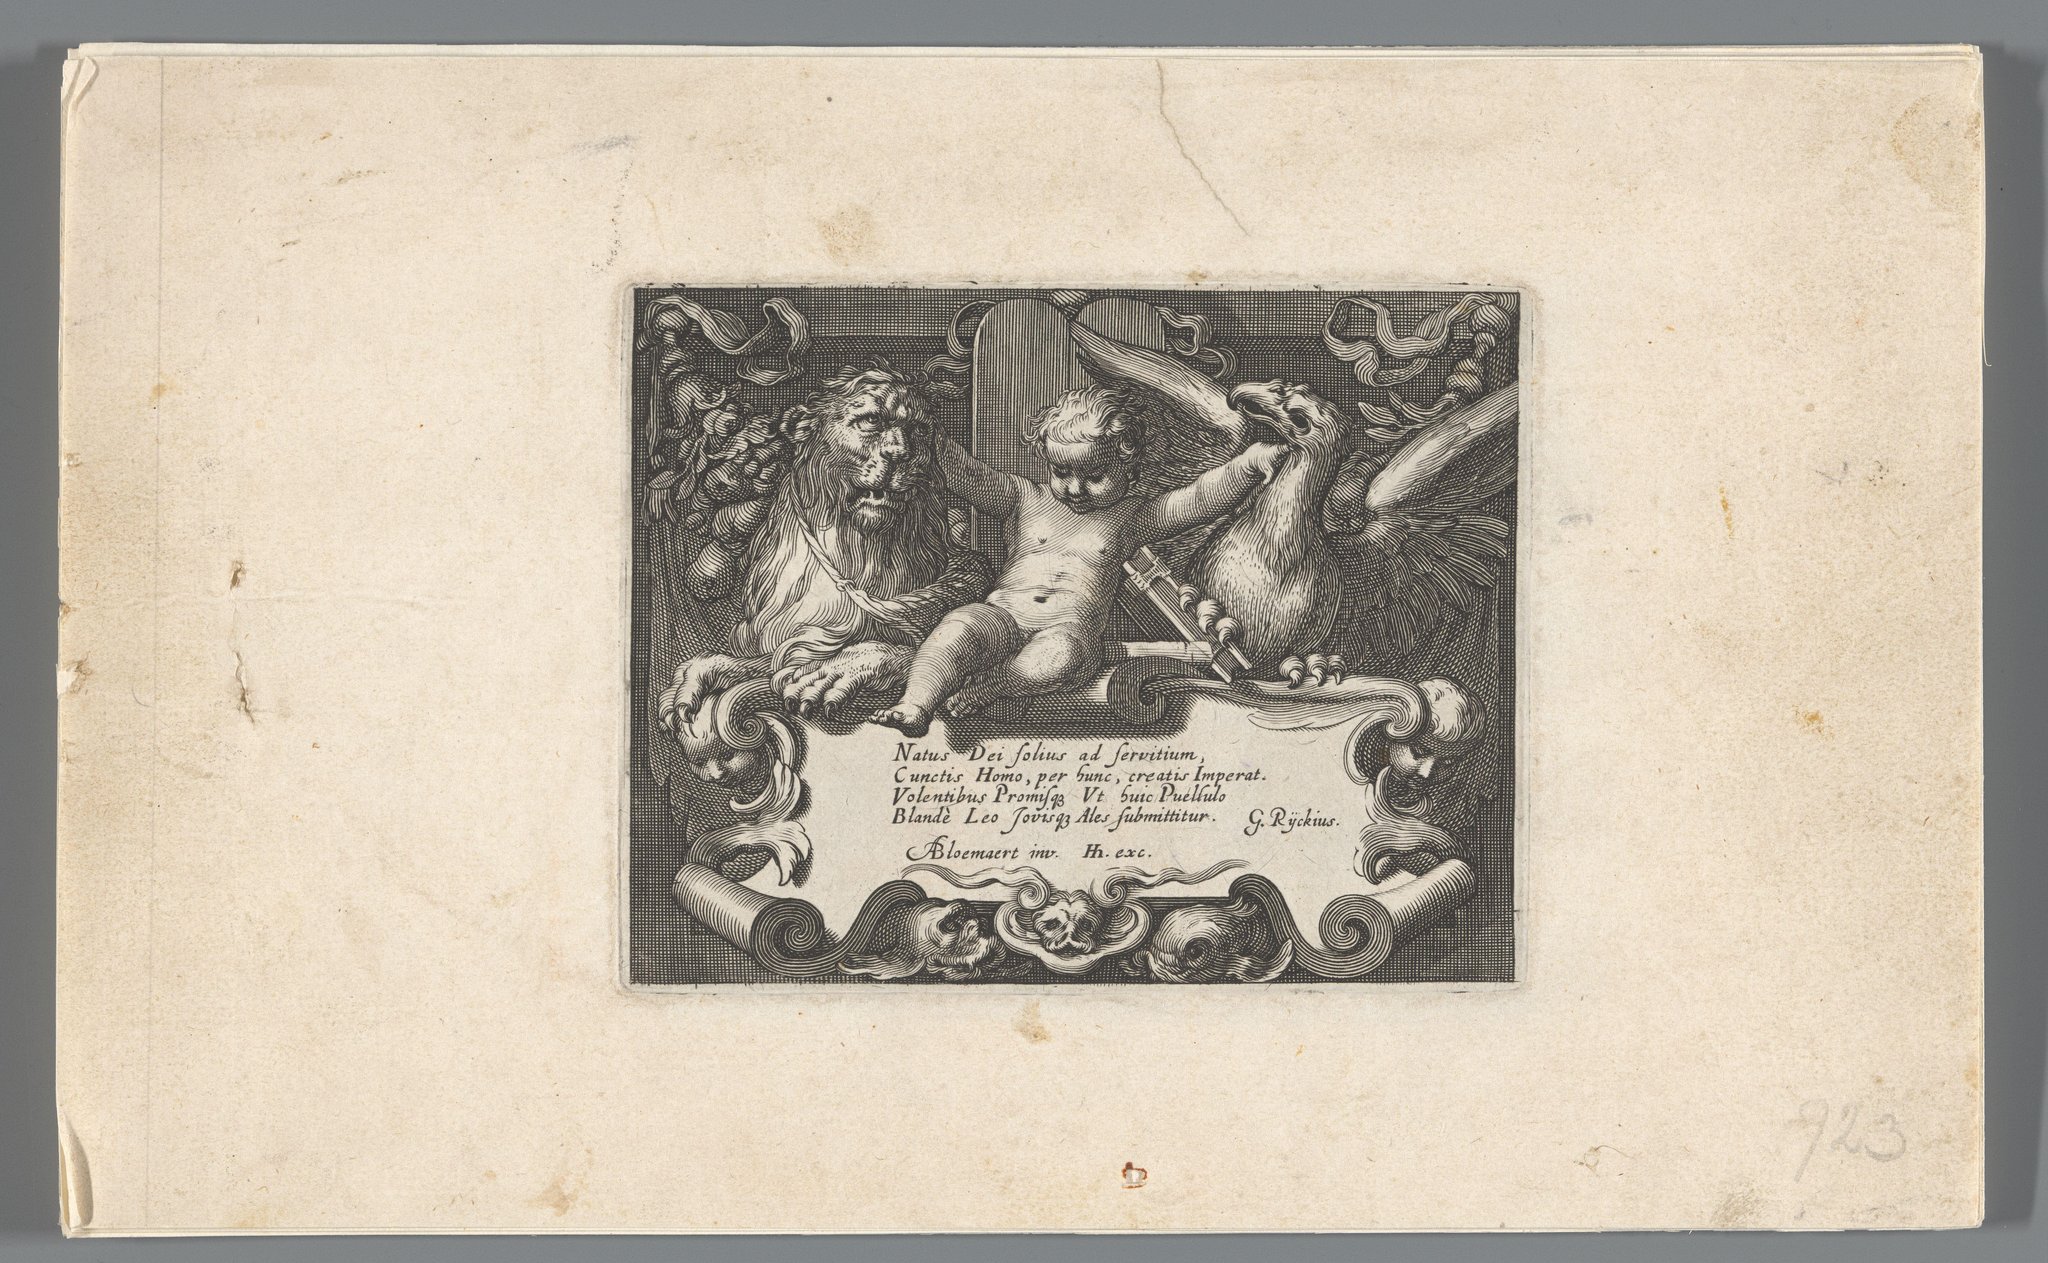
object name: titelprent, frontispice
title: Kind tussen getemde leeuw en roofvogel bovenop cartouche met vers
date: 1611-1650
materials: paper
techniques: engraving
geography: netherlands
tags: dolphin ~ ornament, predatory birds: eagle, man and (wild) animal, beasts of prey, predatory animals: lion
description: Een kind of putto bedaart een leeuw en roofvogel. Zij zitten bovenop een cartouche met een vers in Latijn. Het schild is rijk geornamenteerd met krulwerk, twee cherubijnen en dolfijnen. Volgens het vers toont dit kind door het temmen van de dieren dat de mens door God de leiding over het dierenrijk heeft.